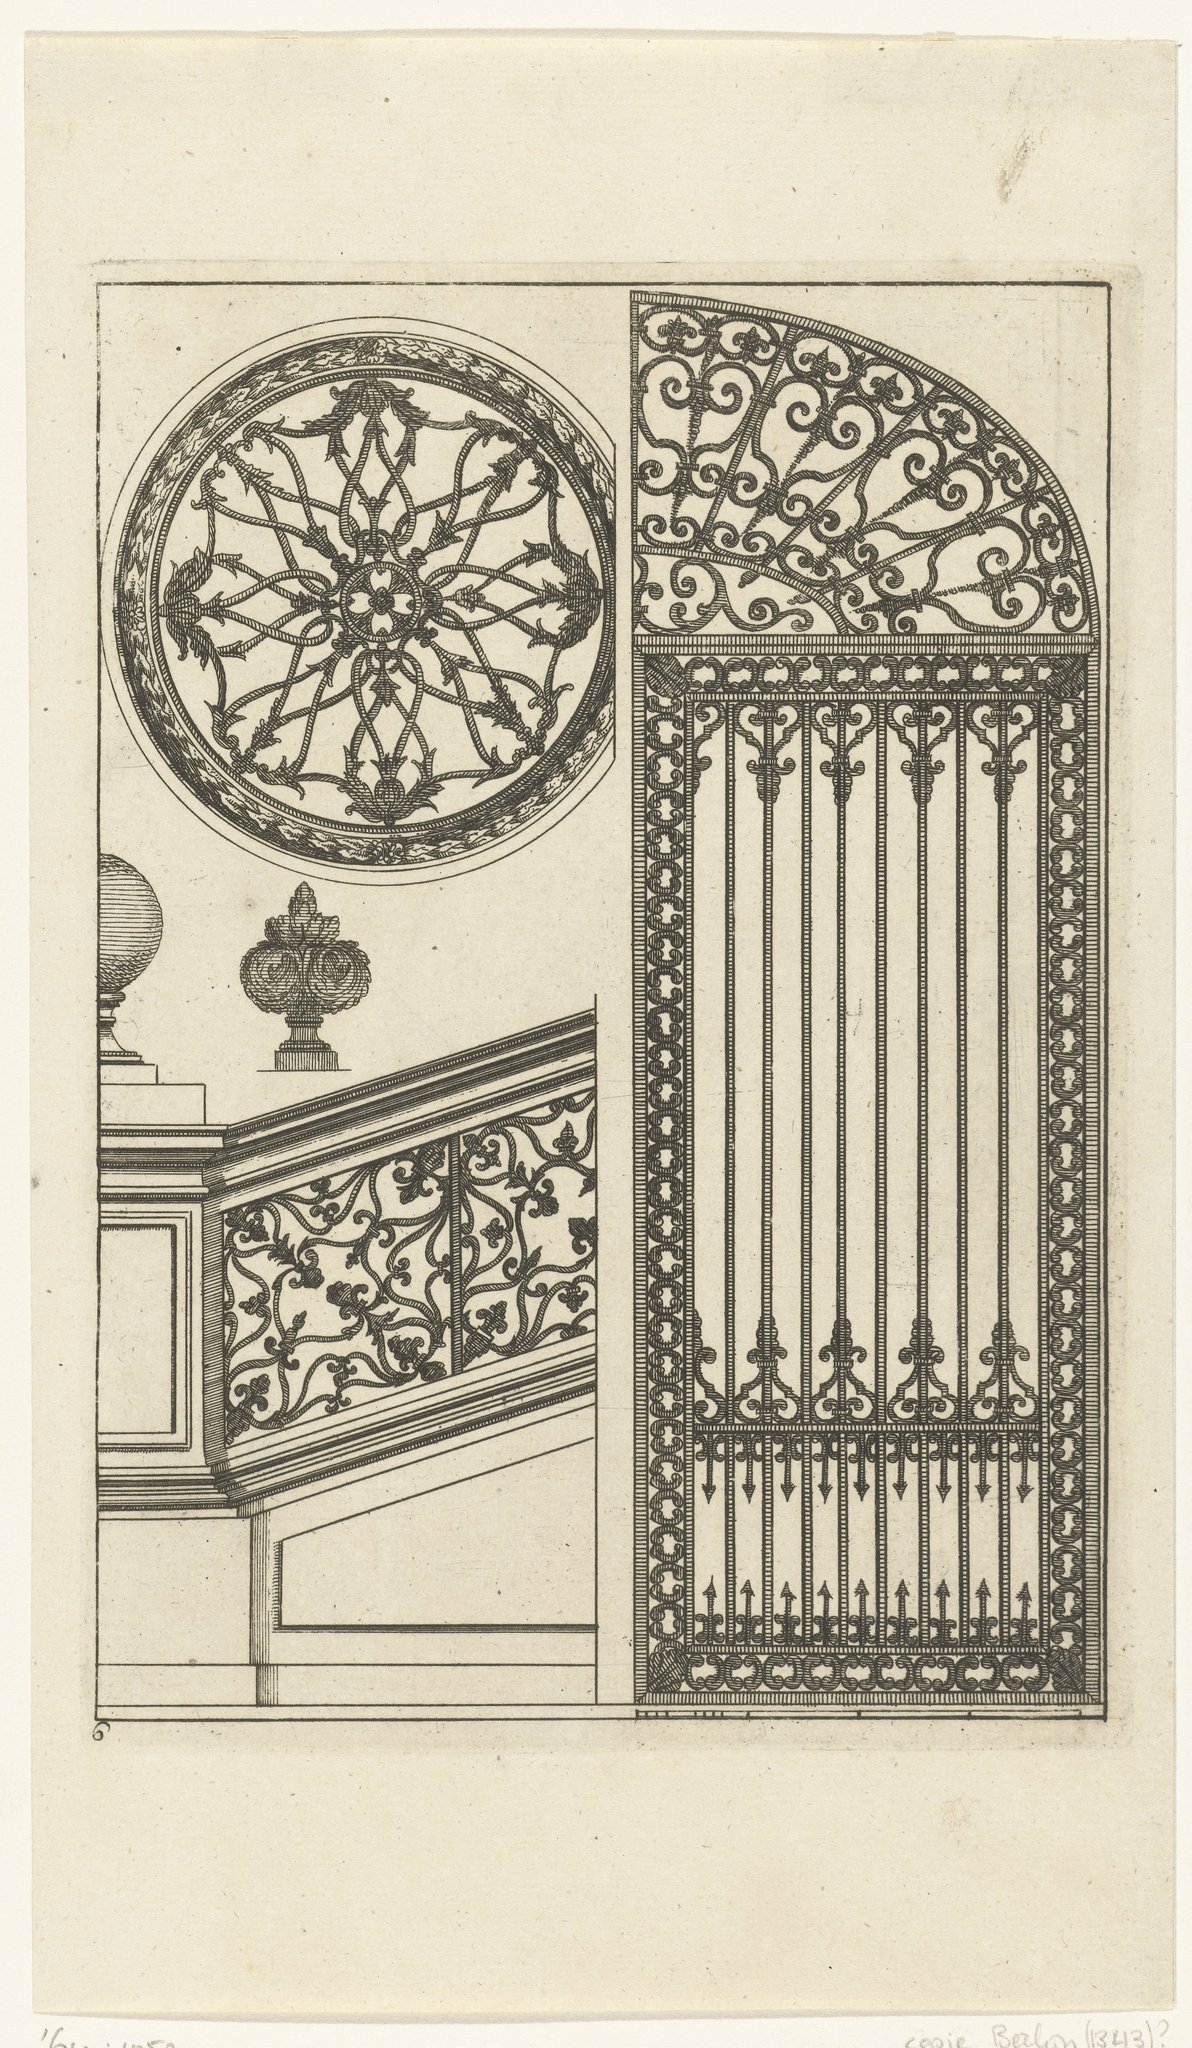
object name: print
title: Hek, trapleuning en twee ornamenten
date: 1726-1750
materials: paper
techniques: etching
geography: amsterdam